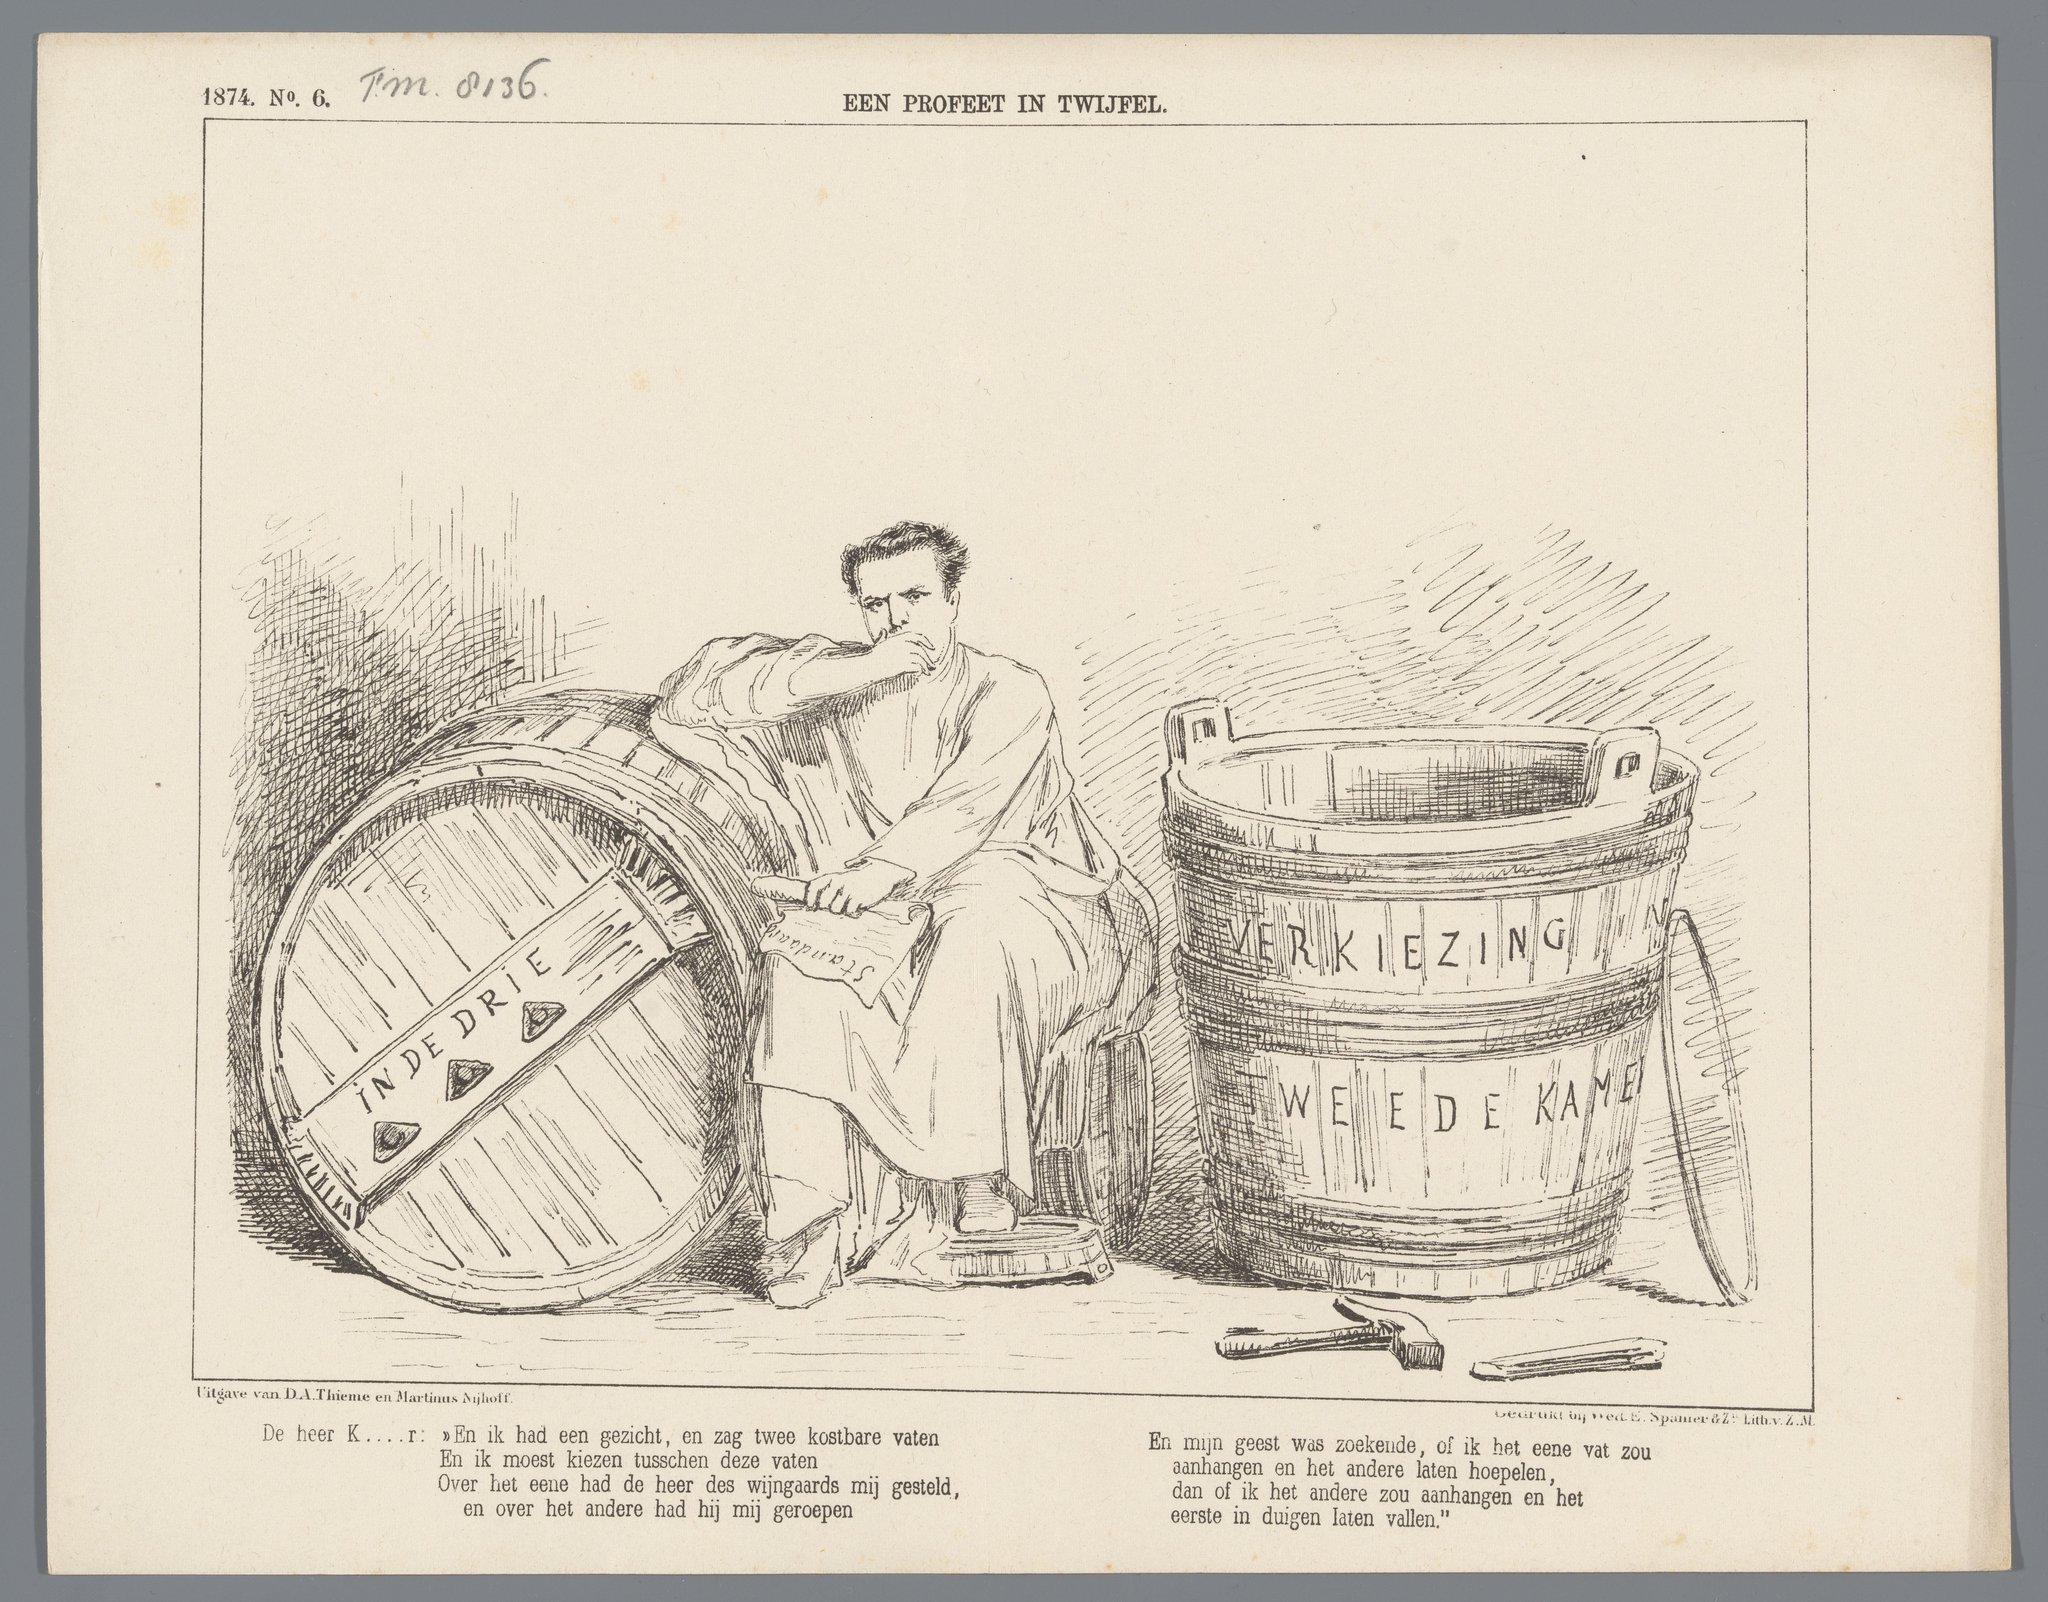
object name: print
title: Spotprent op de verkiezing van Abraham Kuyper in Gouda, 1874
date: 1874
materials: paper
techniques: lithograph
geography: arnhem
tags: the hague, abraham kuyper, wooden container: barrel, cask, bucket, gouda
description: Spotprent op de verkiezing van Abraham Kuyper in Gouda, waardoor hij zijn ambt als predikant te Amsterdam zou moeten neerleggen, 1874. Plaat verschenen bij het weekblad De Nederlandsche Spectator, nr. 6, 1874.